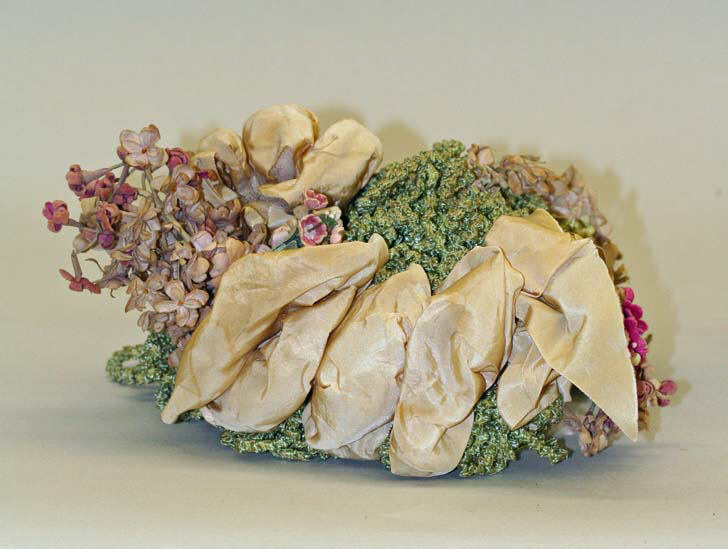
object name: hat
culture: american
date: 1894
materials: silk, fiber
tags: flowers